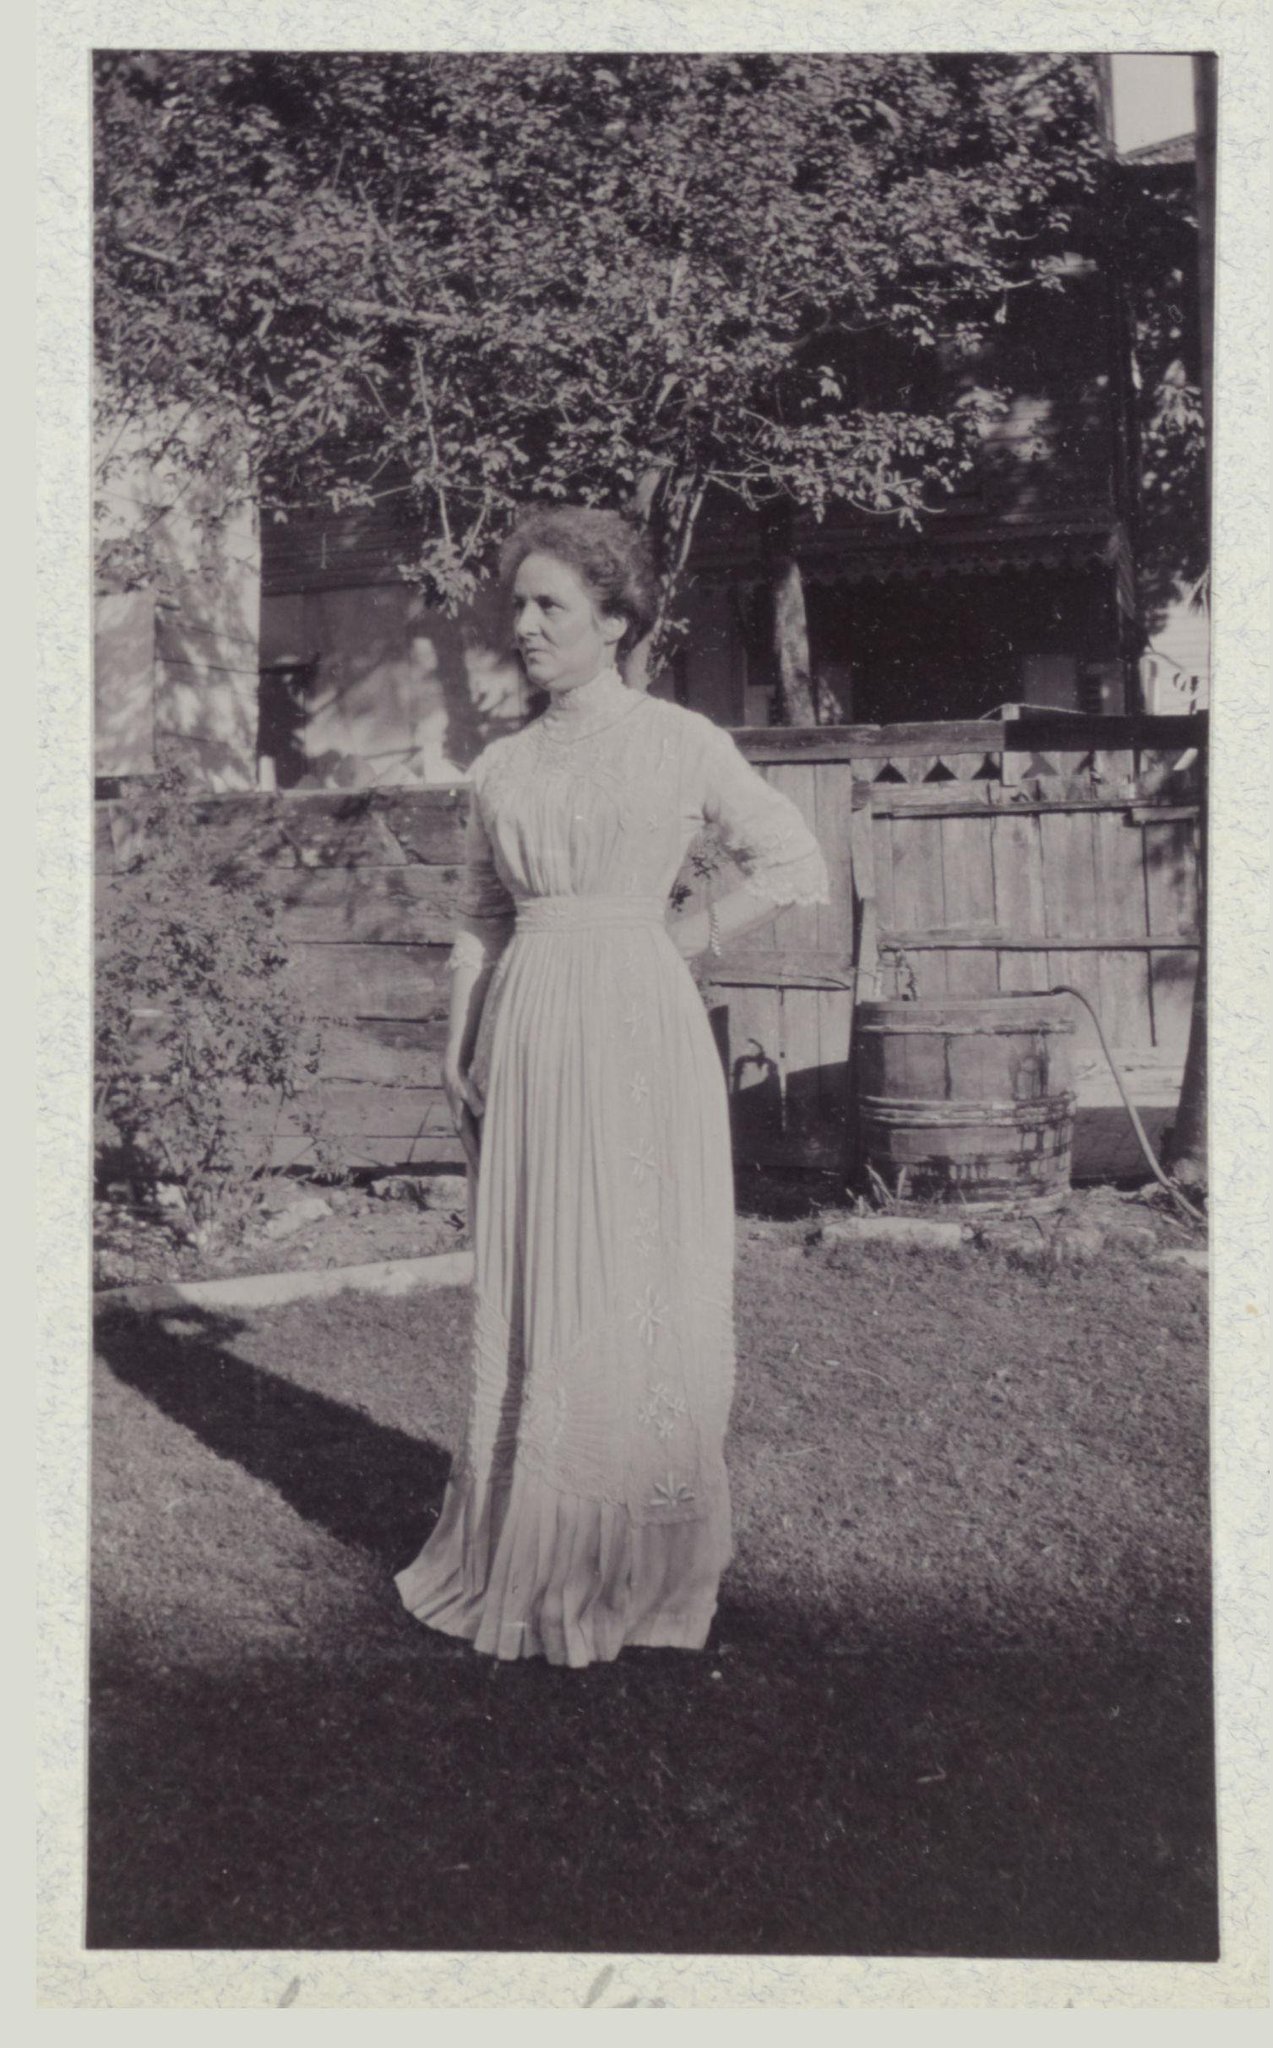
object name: photograph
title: Mevr. Lyon Hall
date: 1911-1912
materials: photographic support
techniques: photography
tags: port-au-prince, haïti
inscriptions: inscription: ‘Mevr. Lyon Hall in haar tuin / Port au Prince. Dec. 11.’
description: Portret van mevr. Lyon Hall, staande in de tuin van haar huis, in Port-au-Prince op Haïti, december 1911. Onderdeel van het fotoalbum van de familie Boom-Gonggrijp in Suriname en Curaçao.